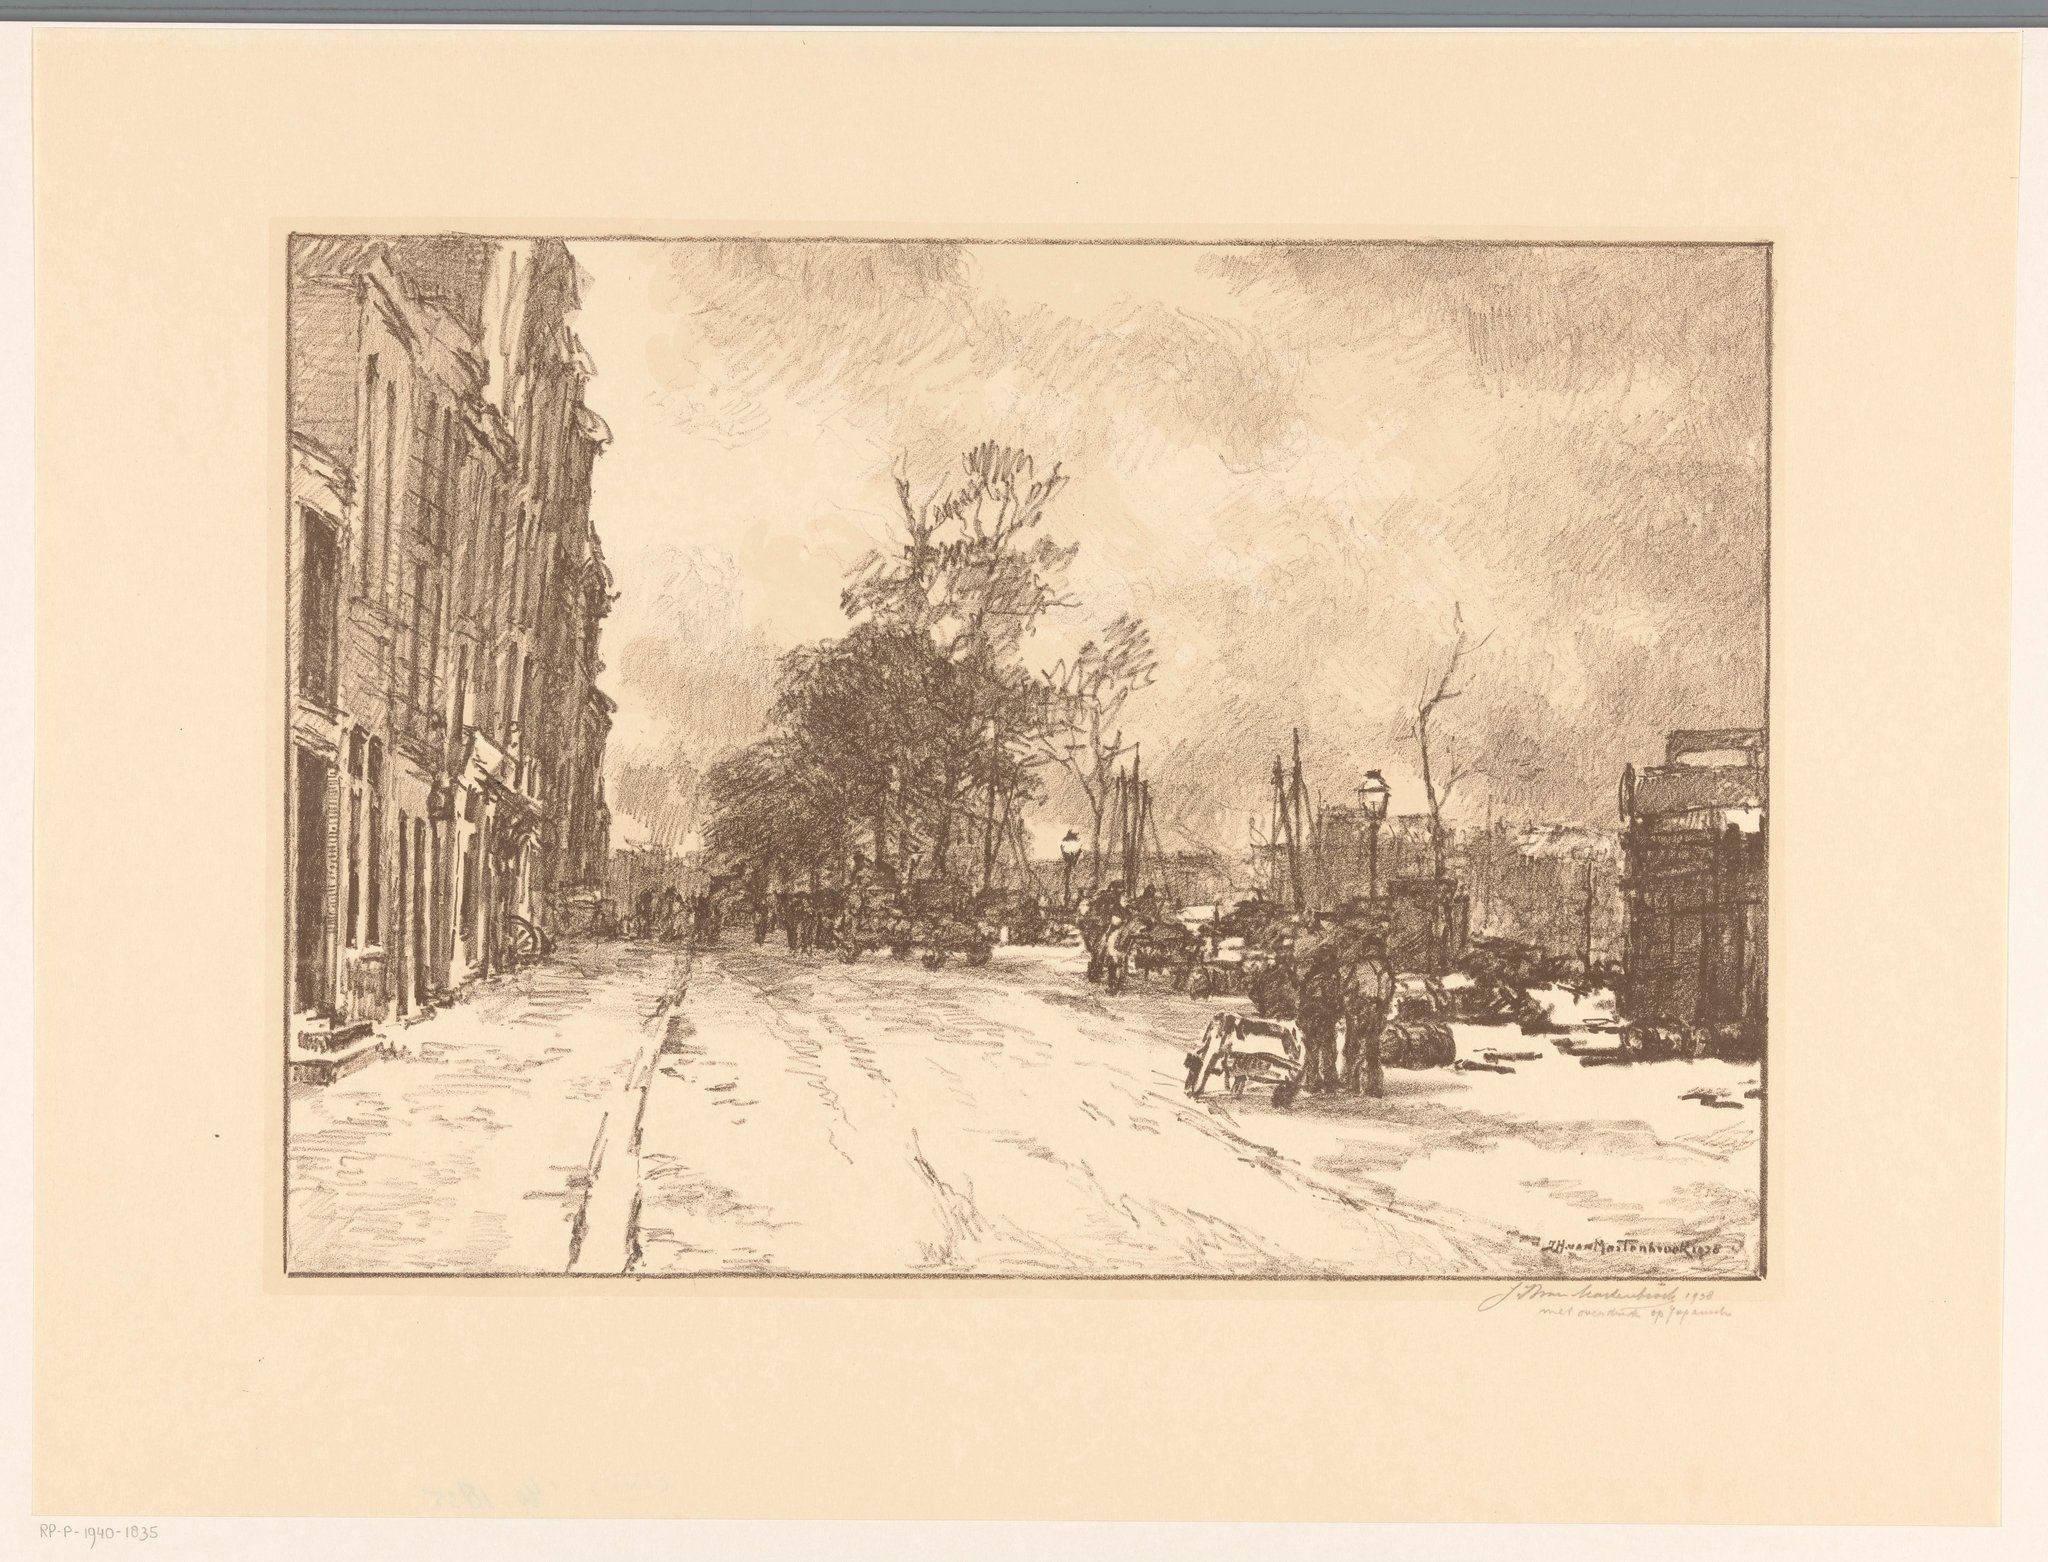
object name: print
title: Straatgezicht in Rotterdam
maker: johan hendrik van mastenbroek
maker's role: painter, print maker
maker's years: 1875-1945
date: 1938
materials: paper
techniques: tone lithography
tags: animal traction, animal-drawn vehicle (carriage etc.), street, rotterdam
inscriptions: collector's mark: Lugt 2228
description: Links aan de straat staan huizen, rechts zijn masten van schepen te zien. Op straat rijden mensen met paard en wagen.